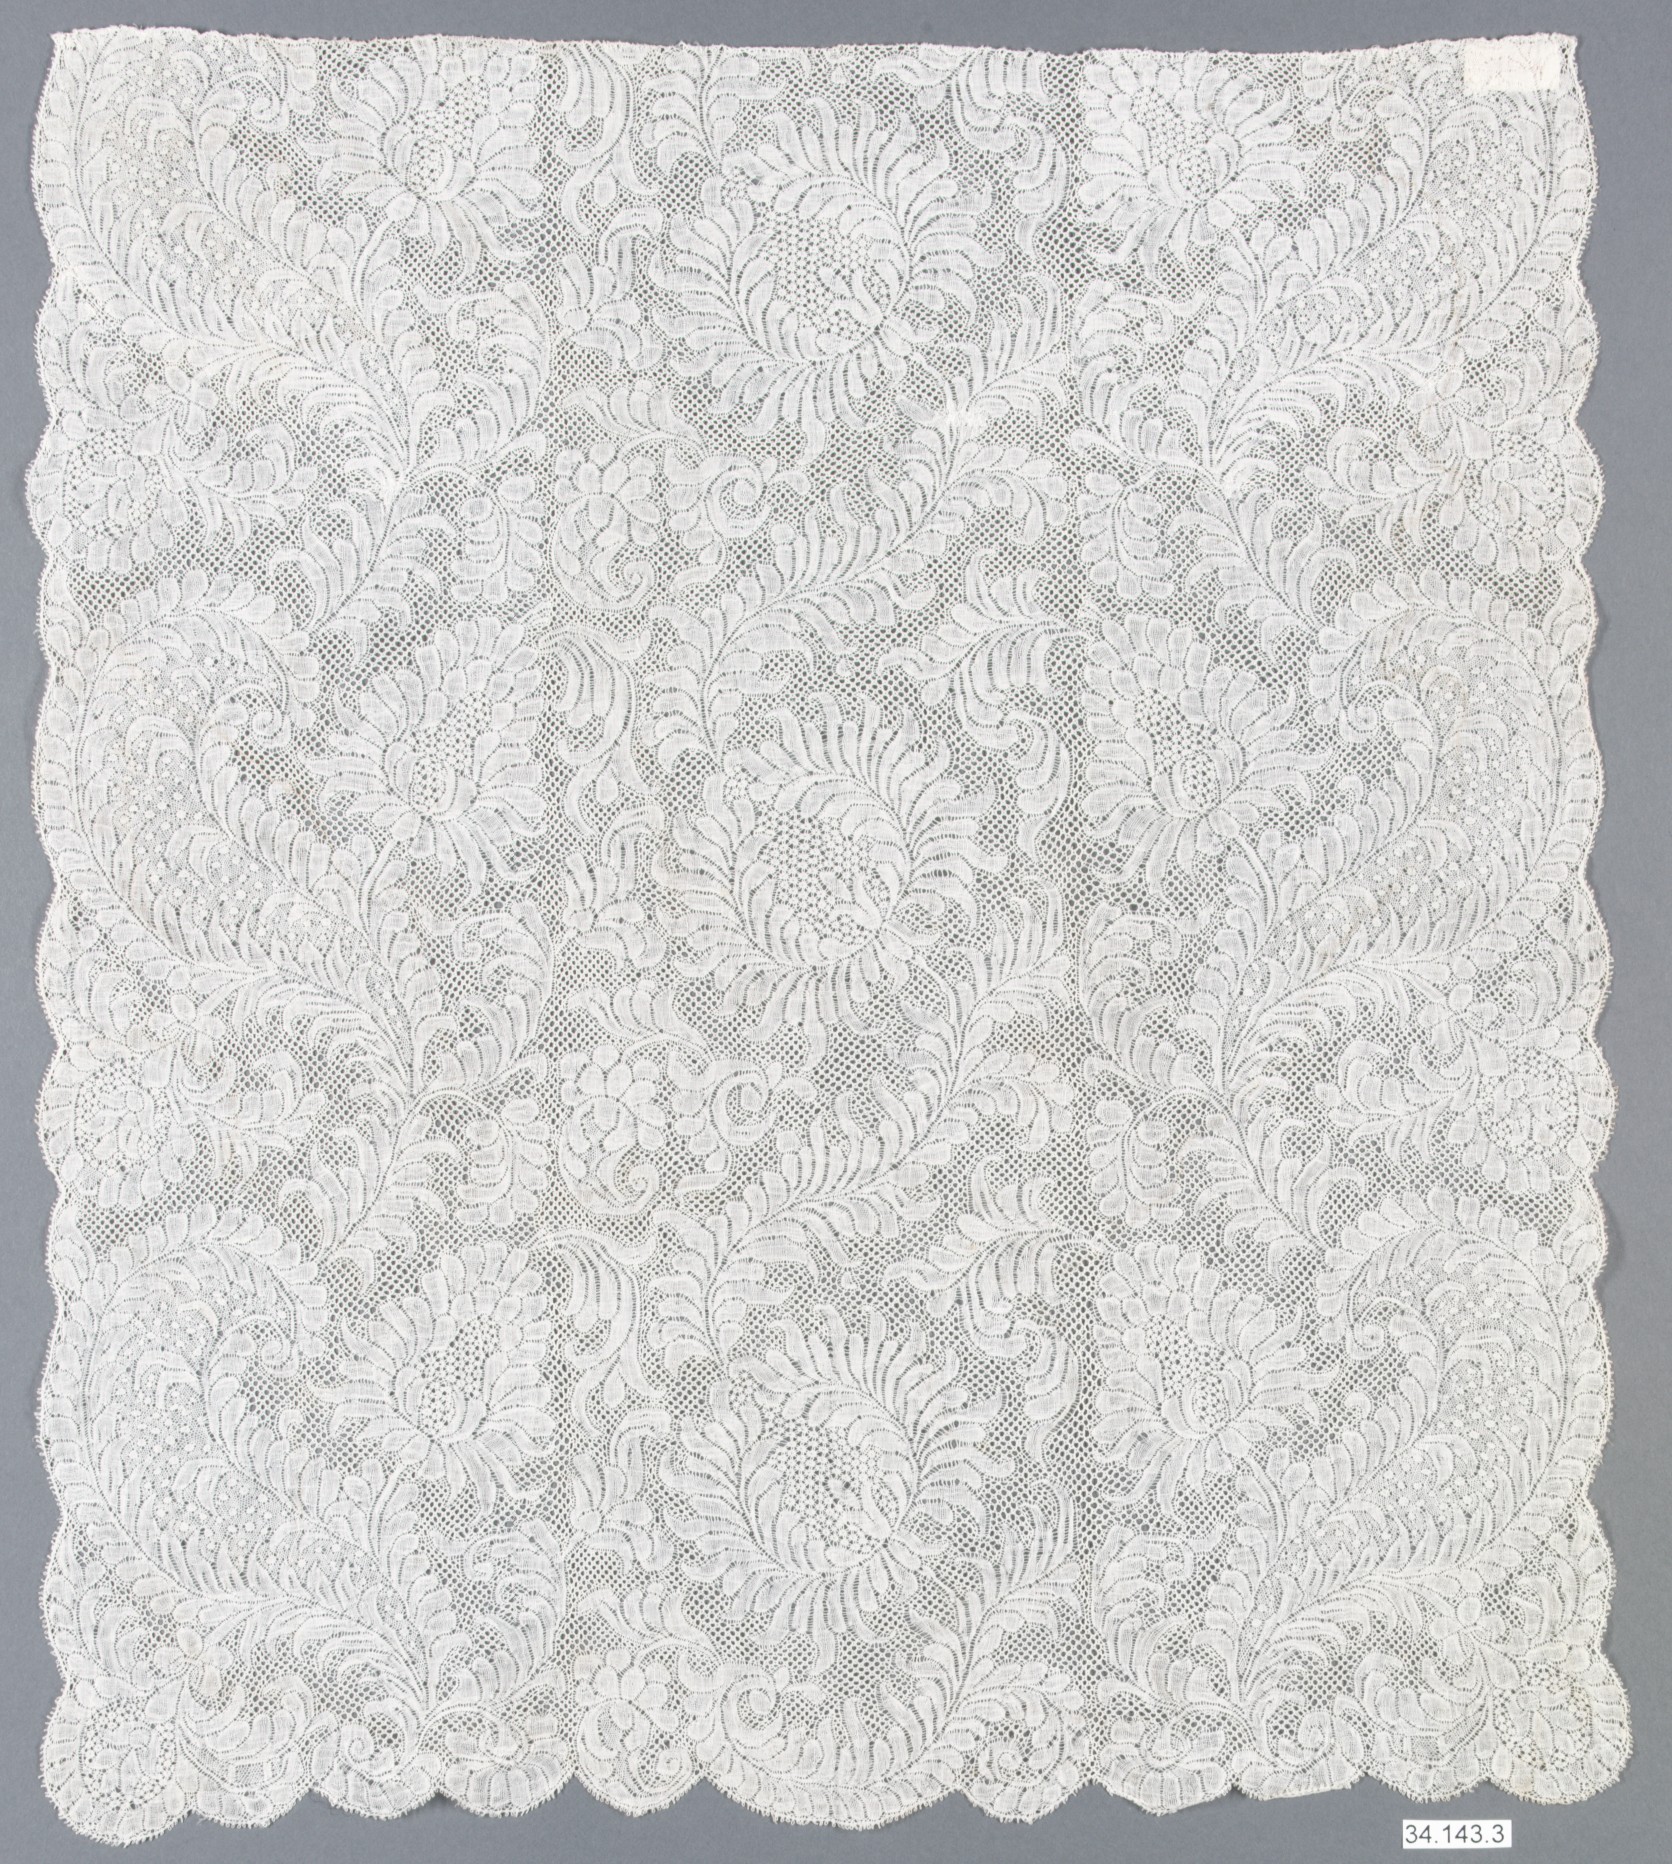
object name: cravat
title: Cravat (one of a pair)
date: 1701-1800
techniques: lace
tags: flowers